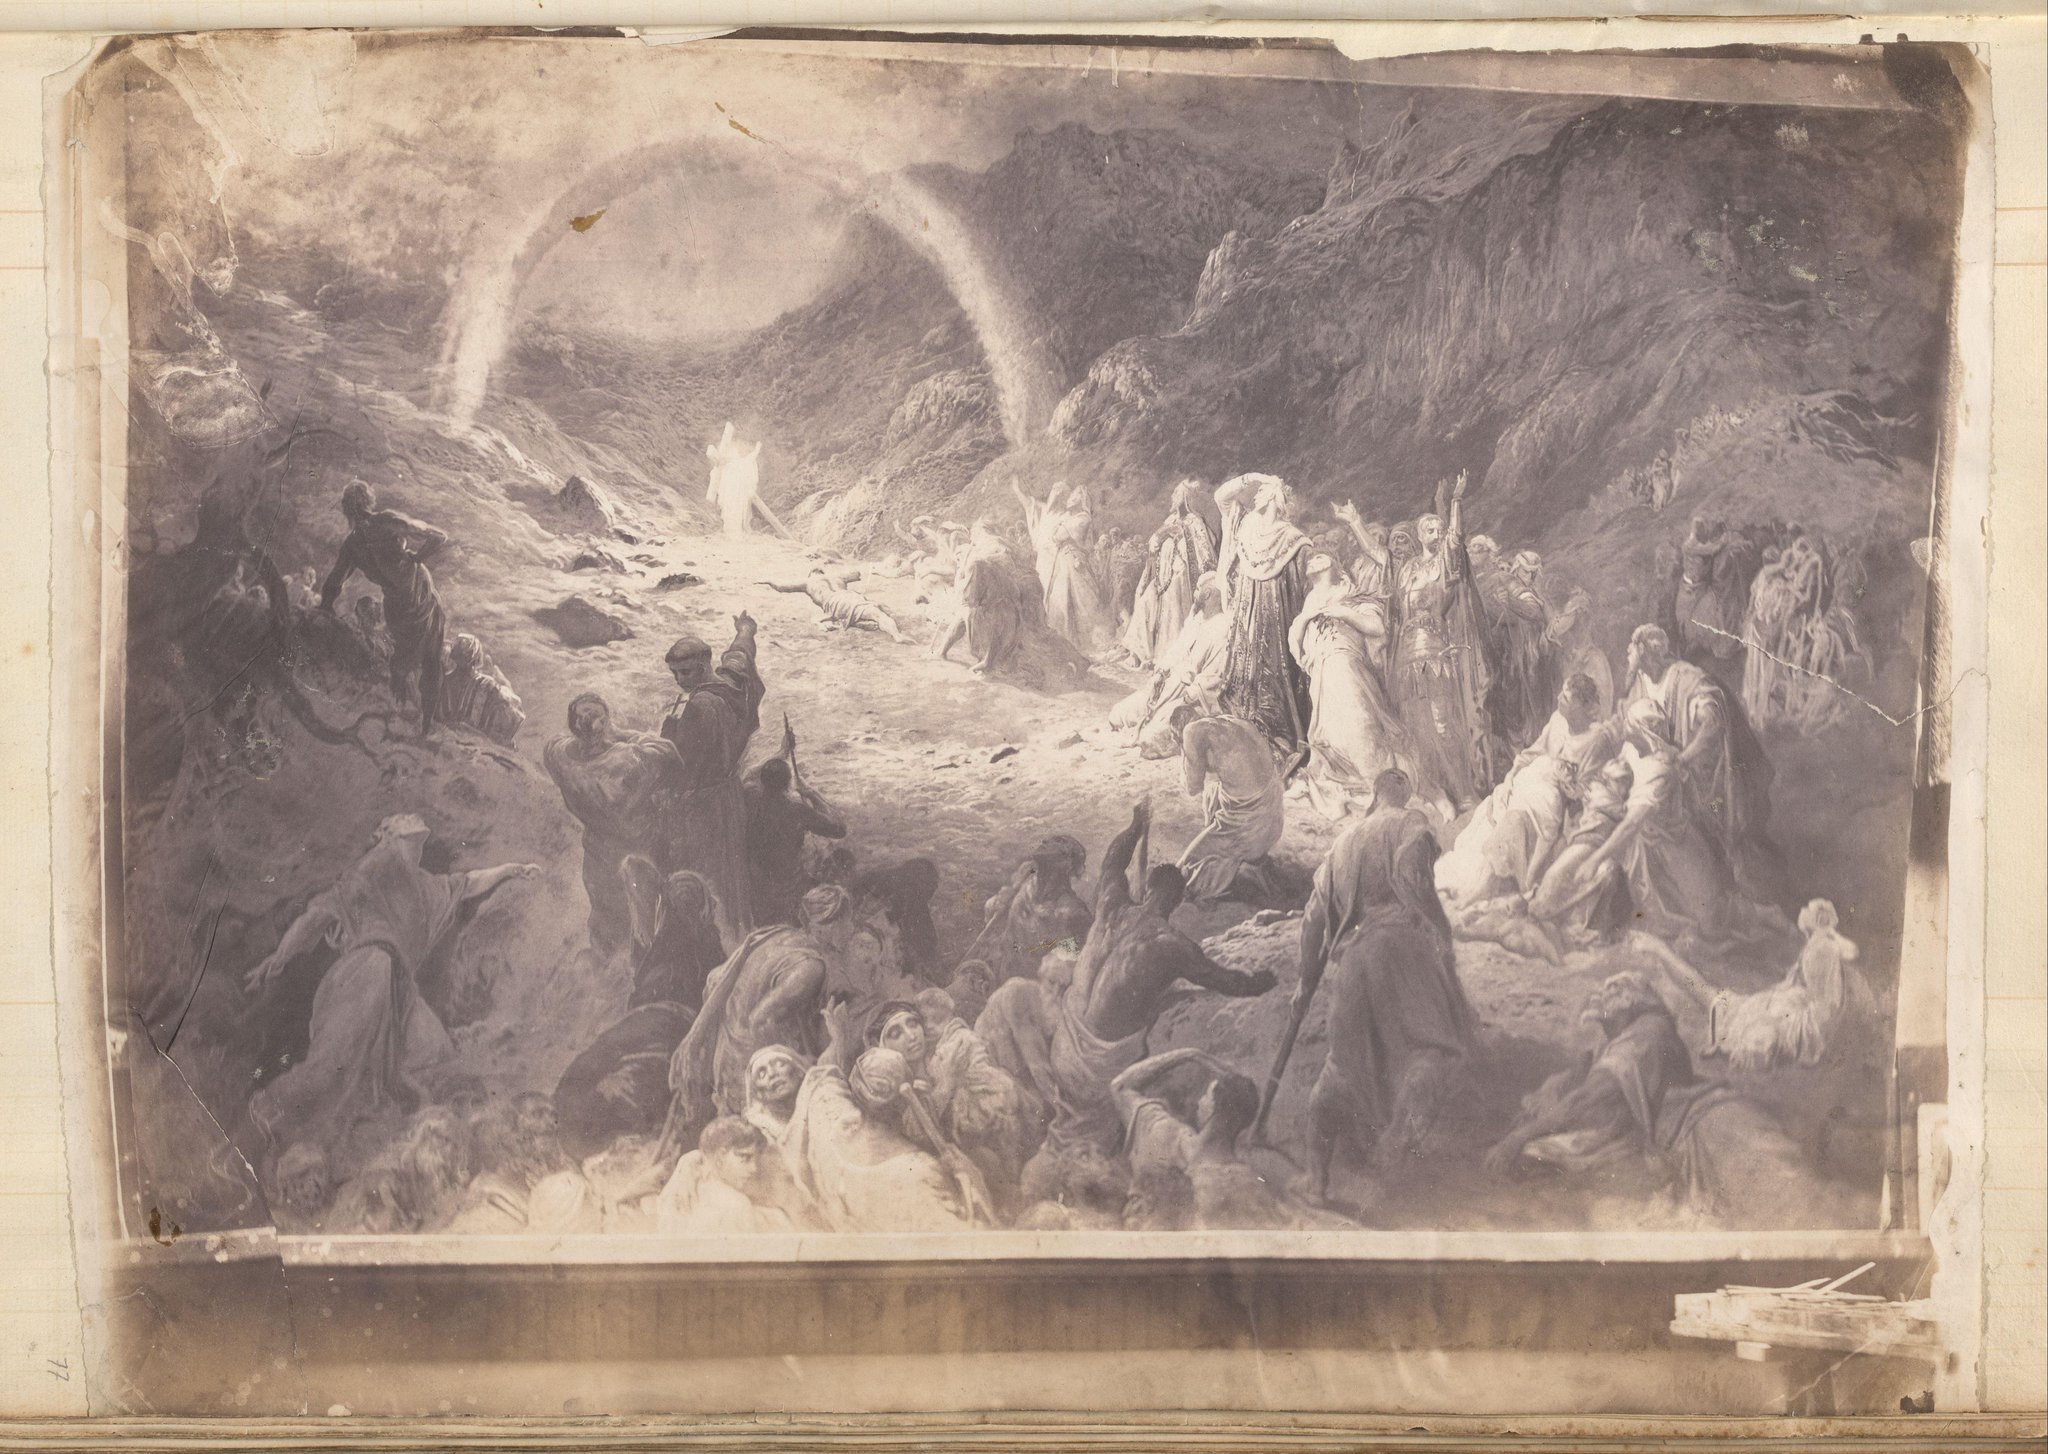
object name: photograph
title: Fotoreproductie van (vermoedelijk) een schilderij voorstellend de wederopstanding van de doden op de Dag des Oordeels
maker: Anonymous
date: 1880-1900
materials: paper, photographic support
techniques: salted paper print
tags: resurrection of the dead ~ last judgement